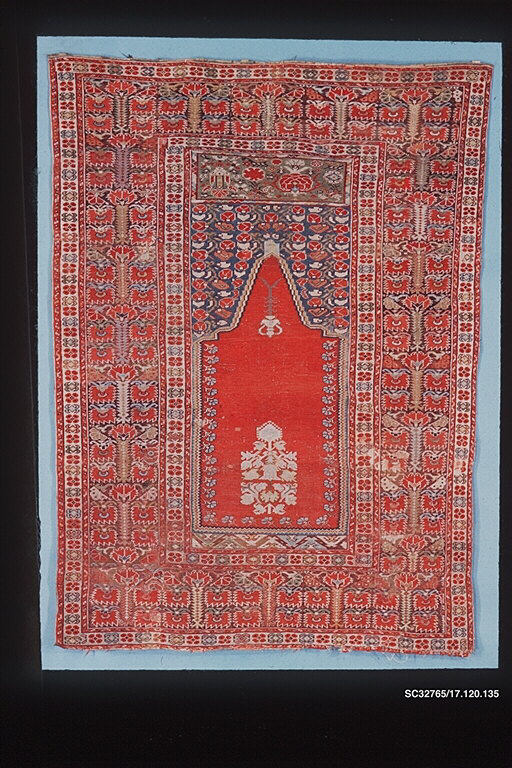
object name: carpet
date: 1801-1900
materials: wool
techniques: pile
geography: turkey